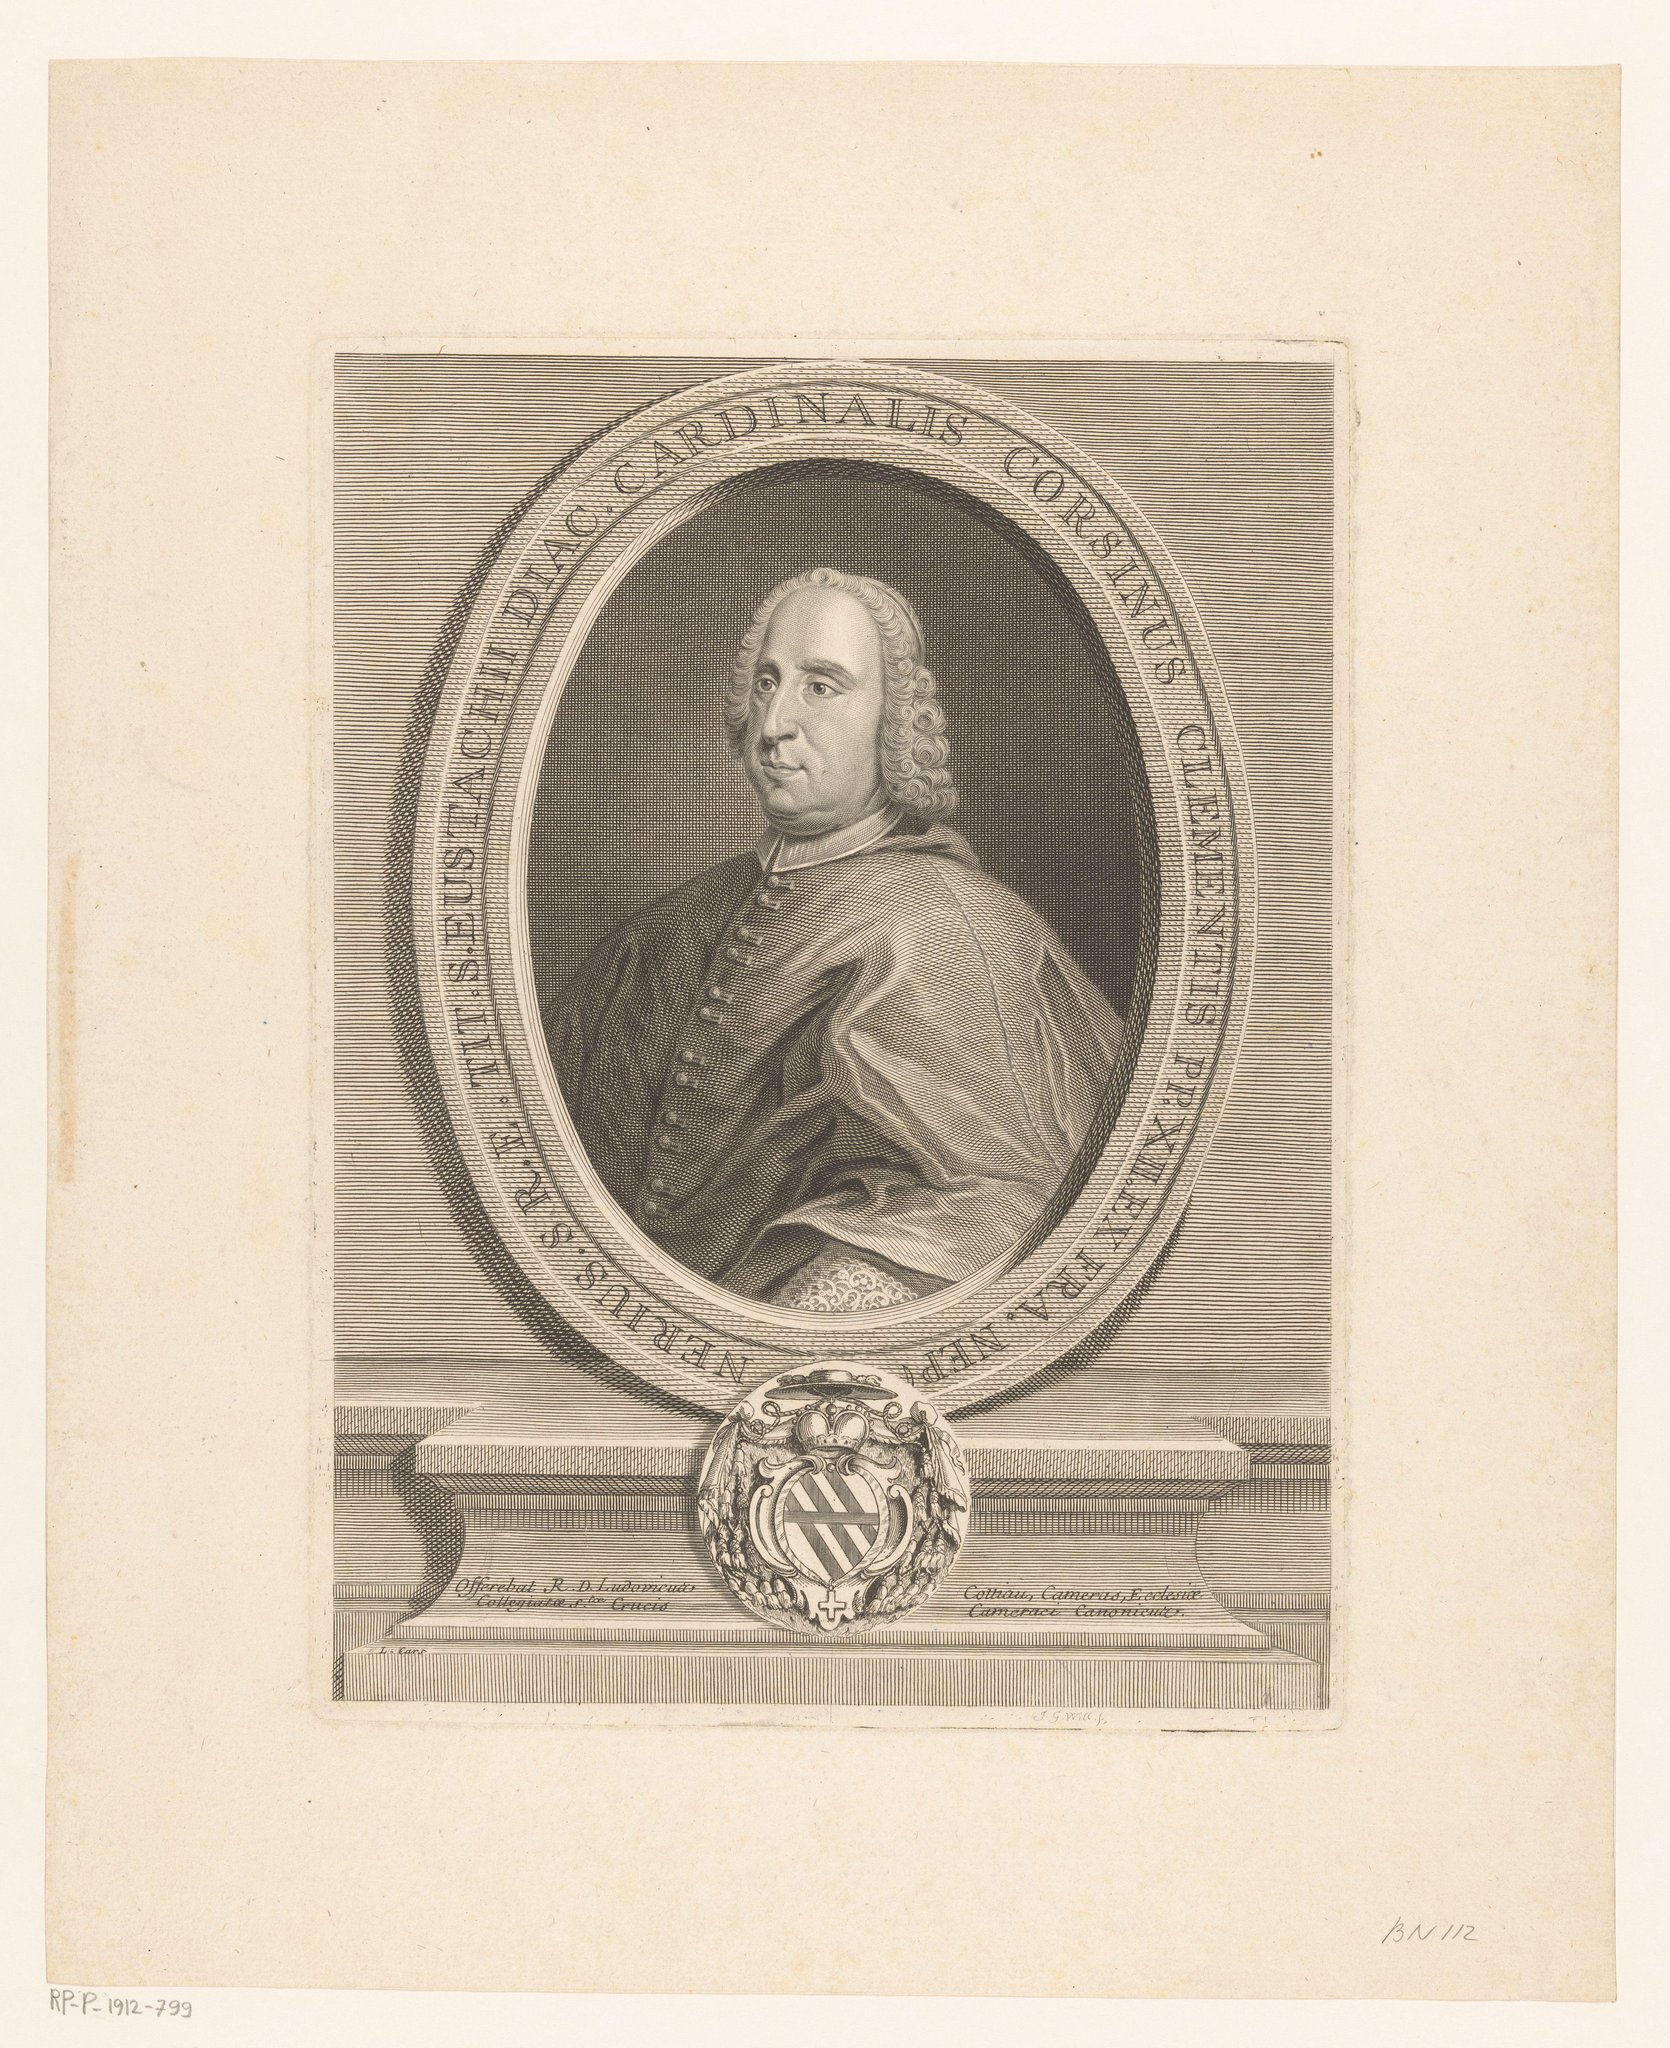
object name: print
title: Portret van kardinaal Lorenzo Corsini, de latere paus Clemens XII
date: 1725-1771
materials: paper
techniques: engraving, etching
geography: france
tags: rome, clemens xii, historical persons, pope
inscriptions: collector's mark: Lugt 2228